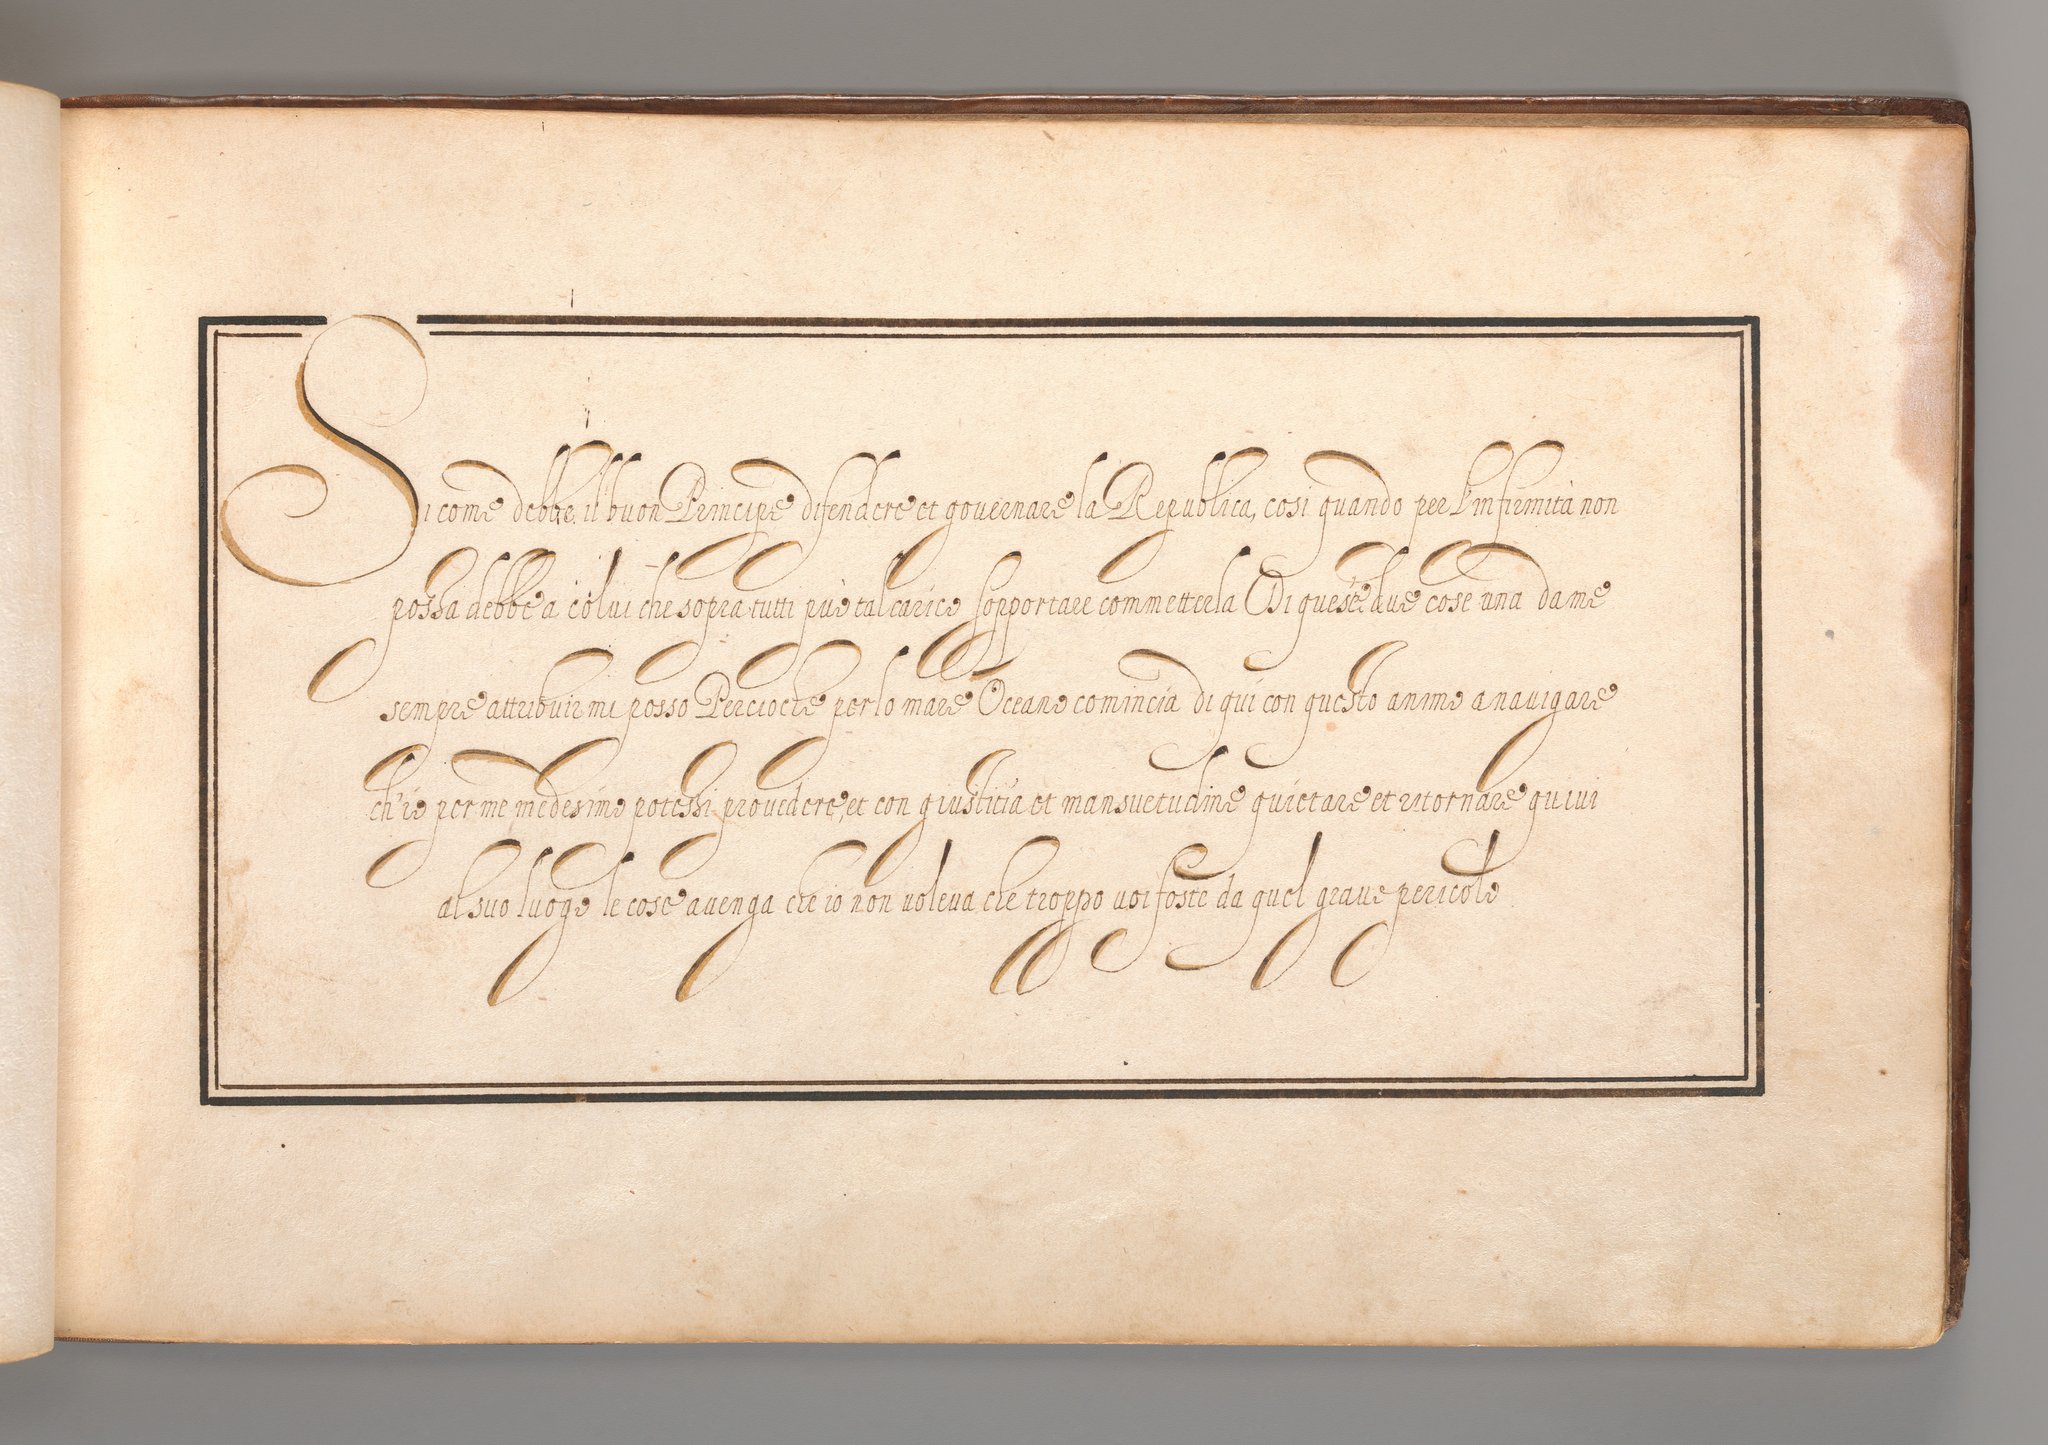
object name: album print ornament architecture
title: Calligraphic Exercise in Italian (Cursive Script)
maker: Anonymous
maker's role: artist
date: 1601-1633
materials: ink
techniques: pen